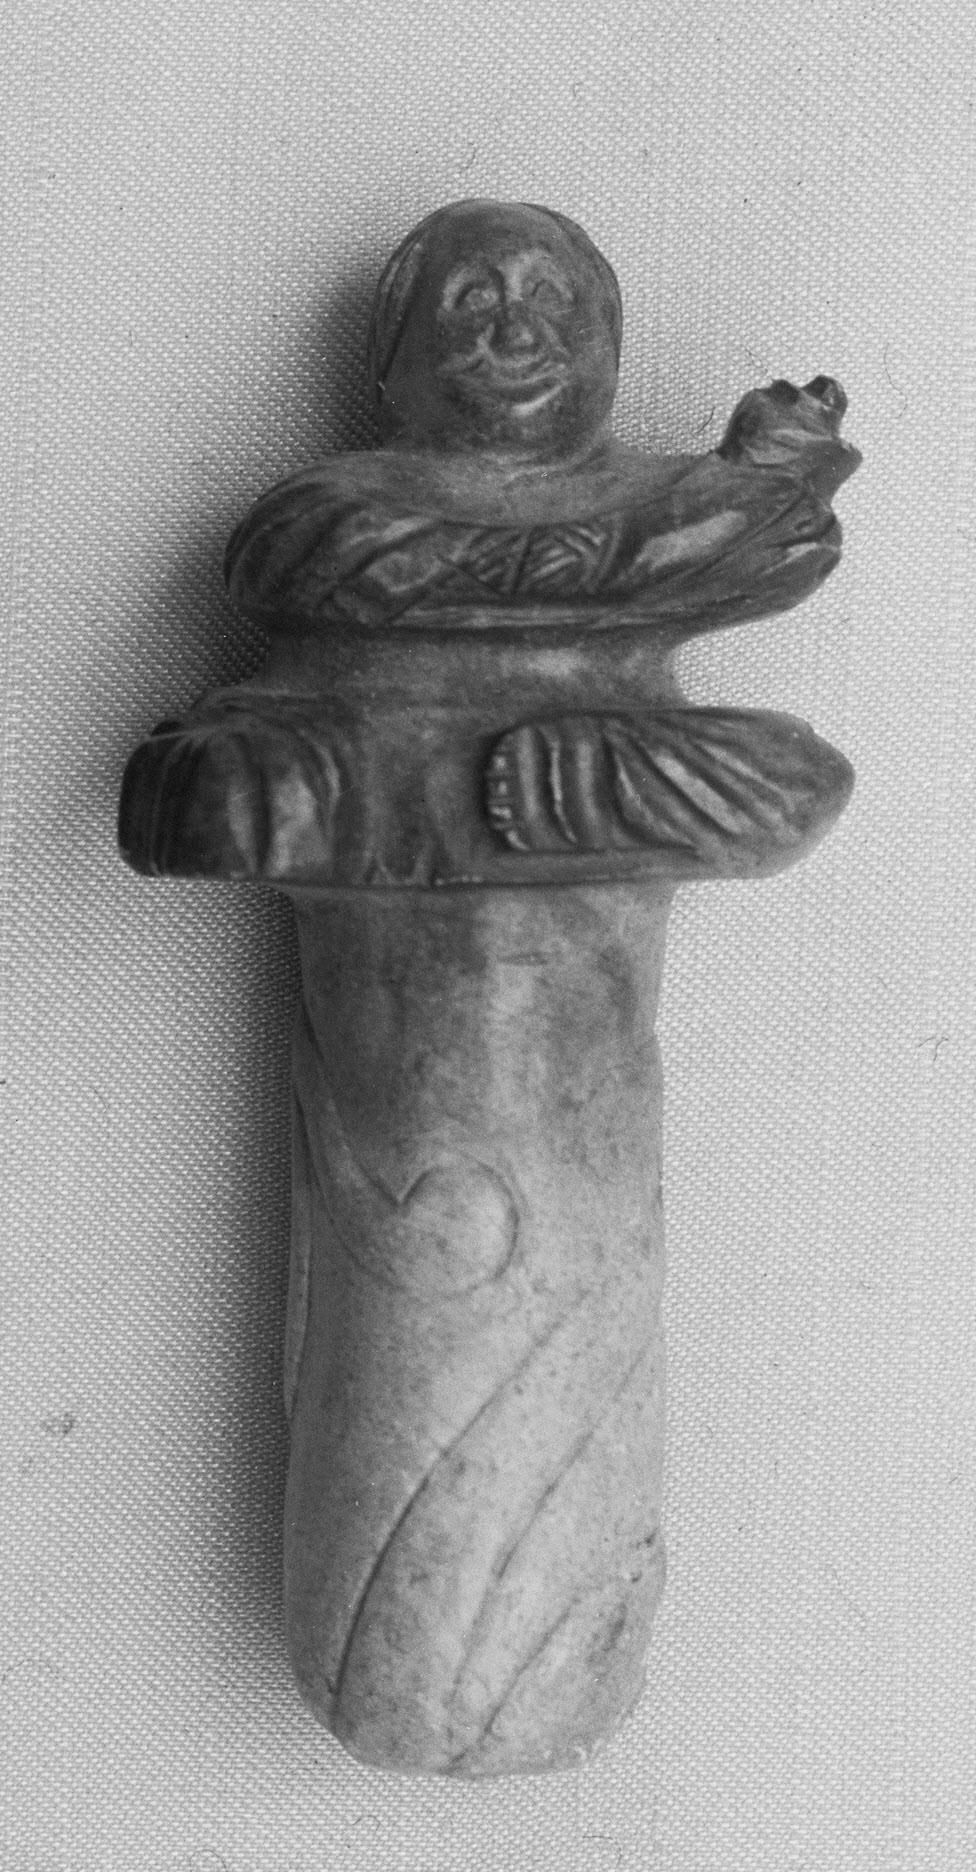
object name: finial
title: Finial with child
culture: chinese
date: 1368-1644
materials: jade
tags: men